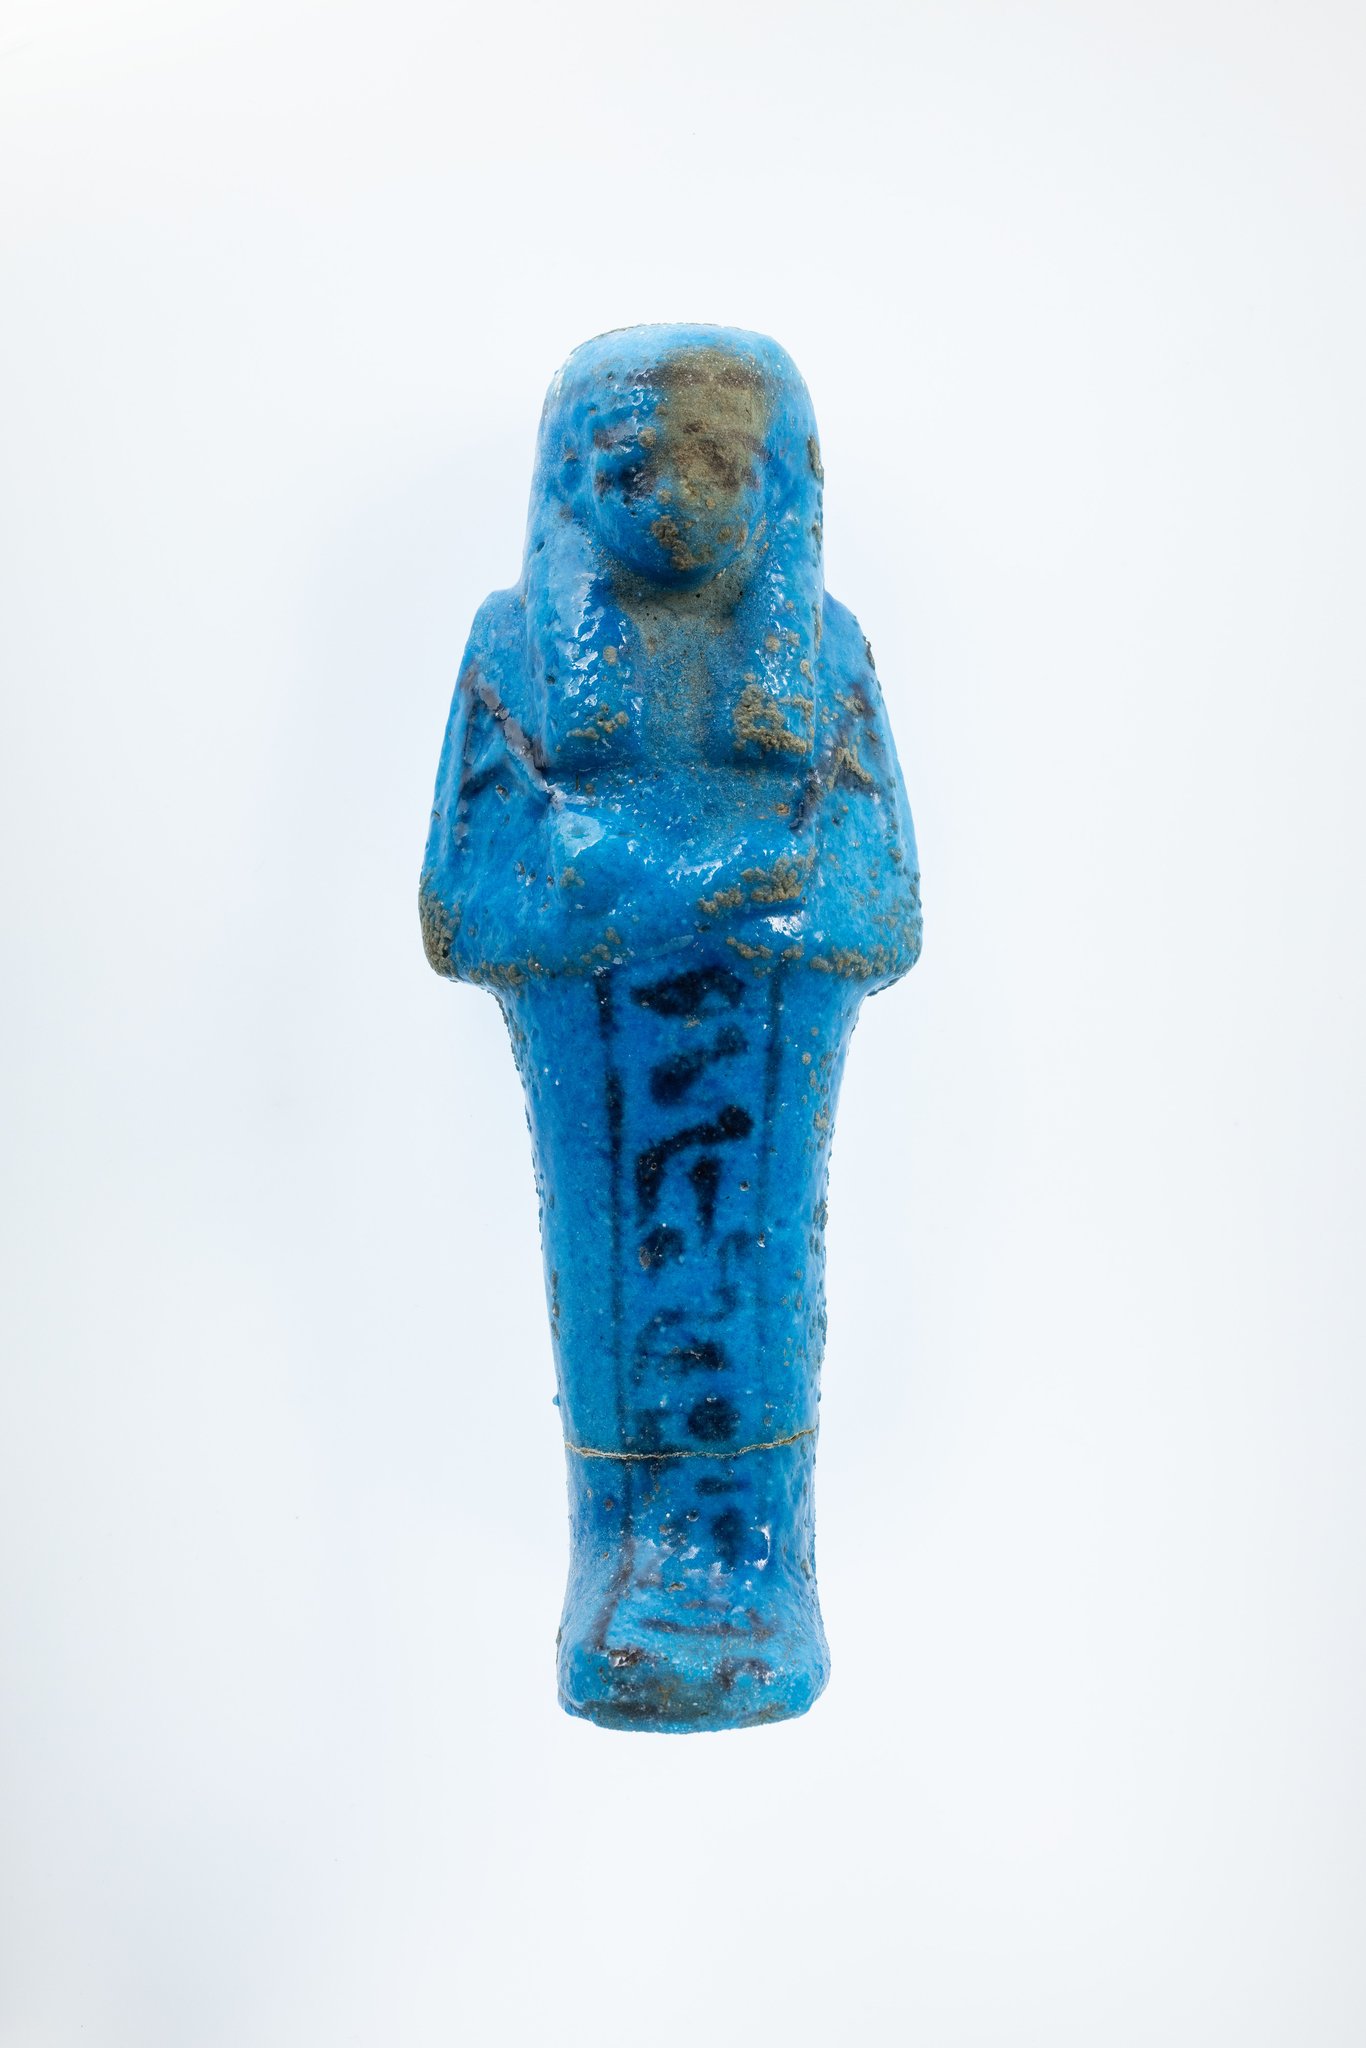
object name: shabti, djedkhonsuefankh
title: Shabti of Djedkhonsuefankh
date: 1070-945 BCE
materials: faience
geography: egypt